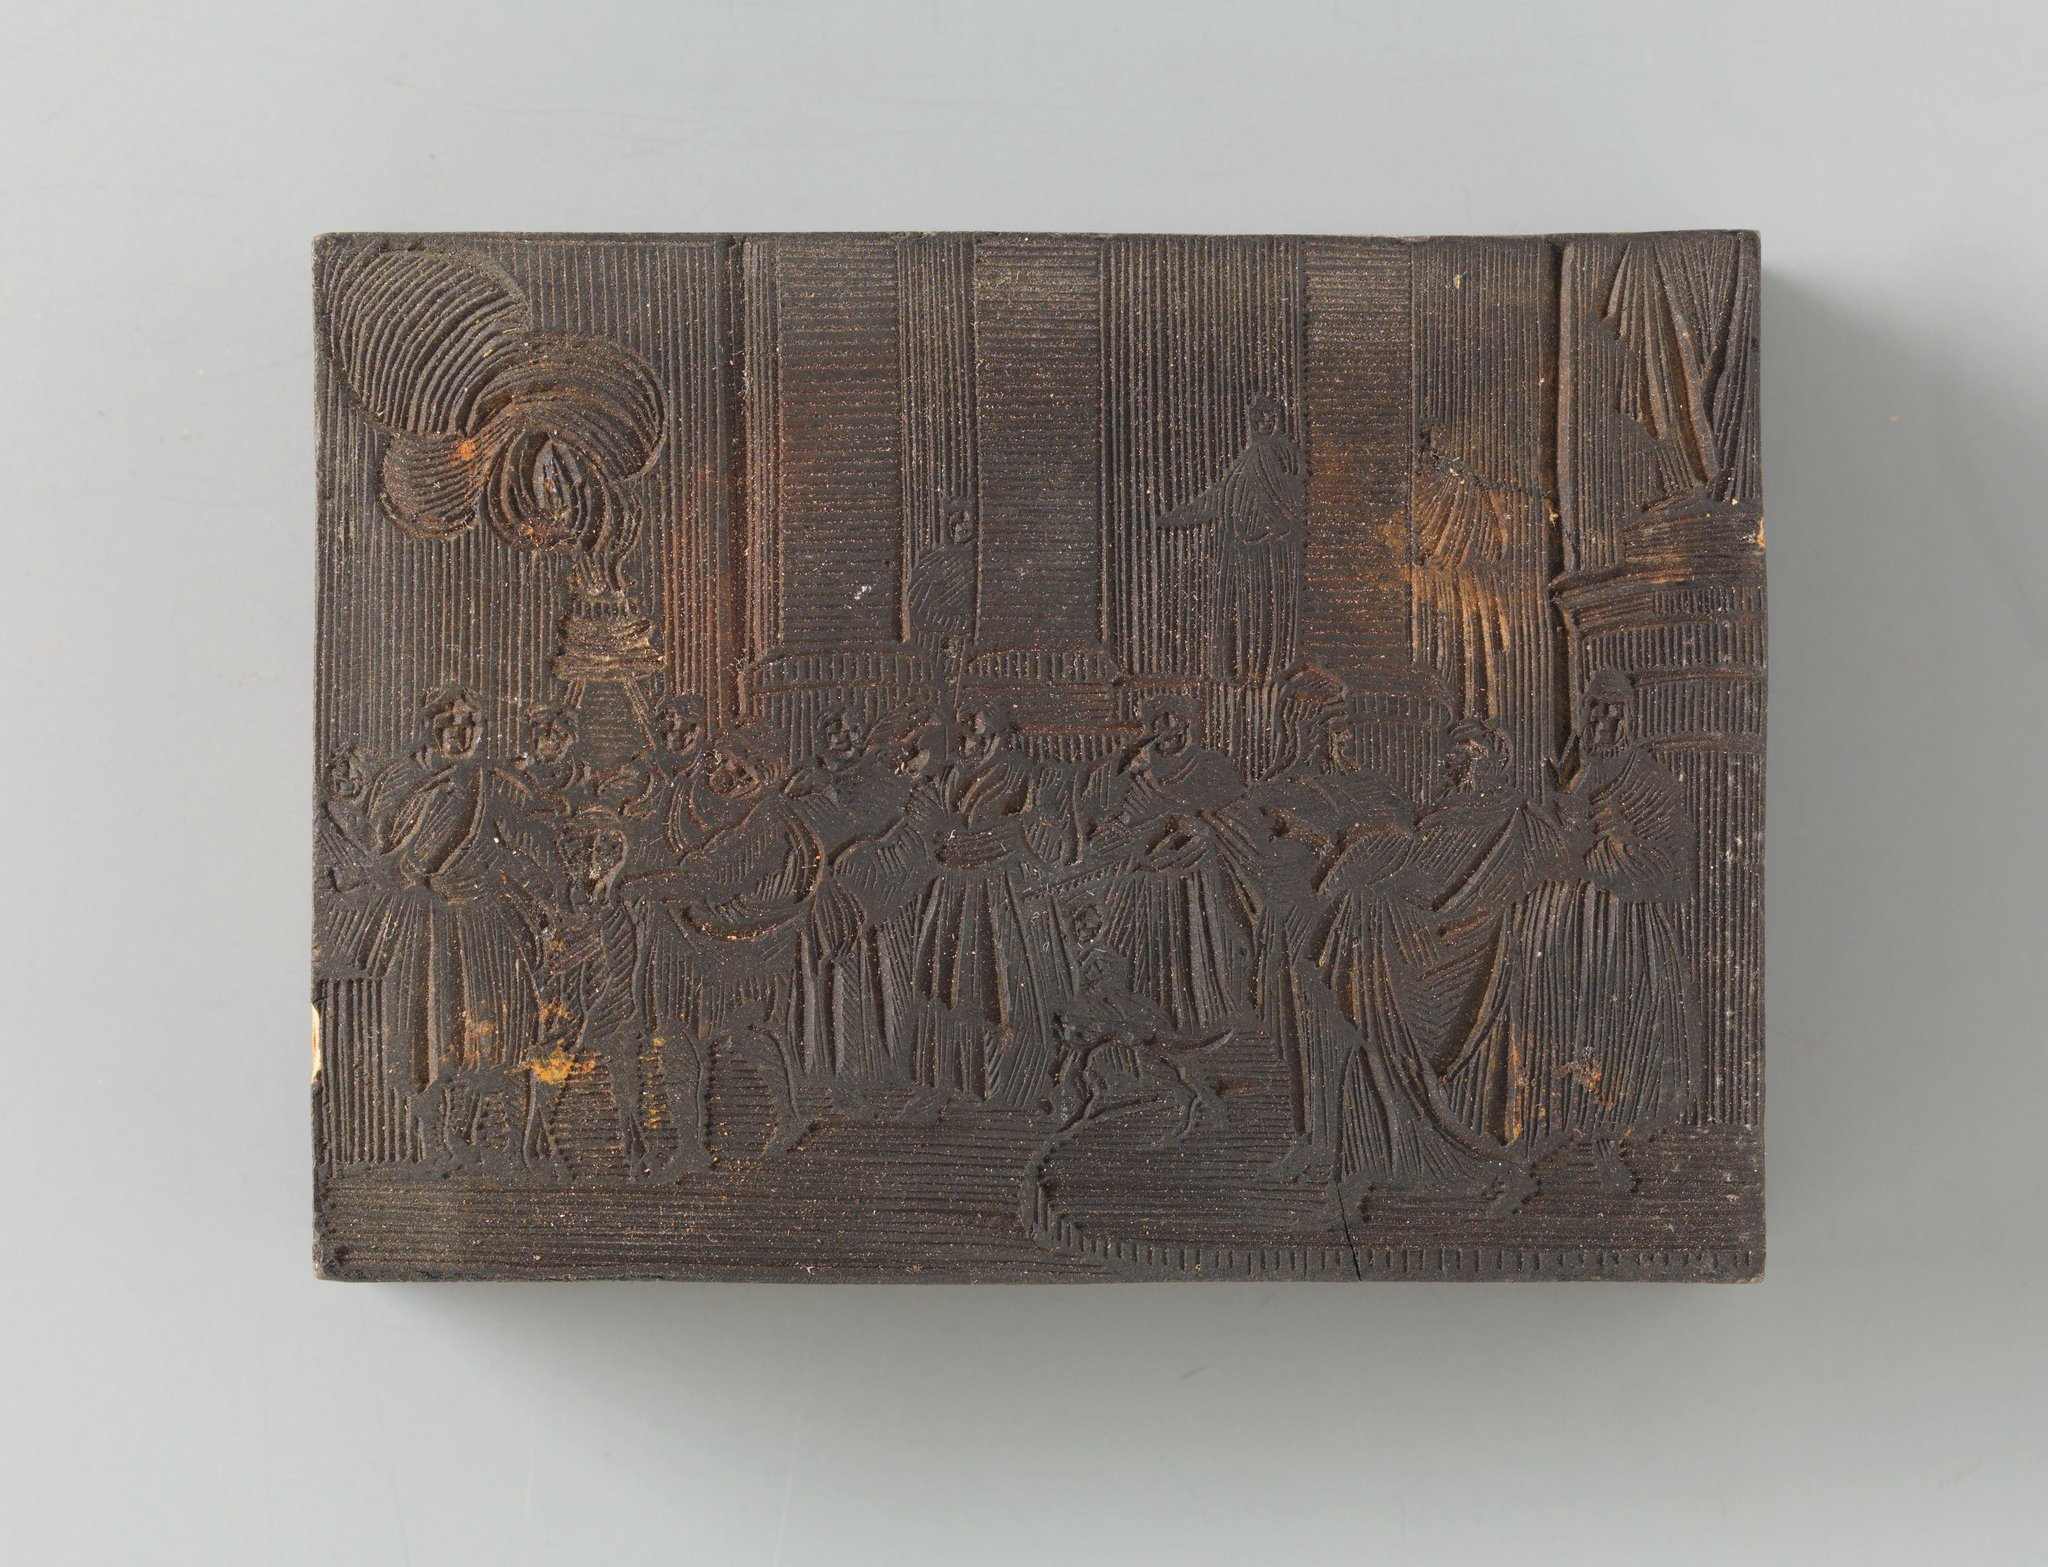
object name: wood block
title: Bijbel-illustraties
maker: Anonymous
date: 1550-1699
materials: wood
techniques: woodcut